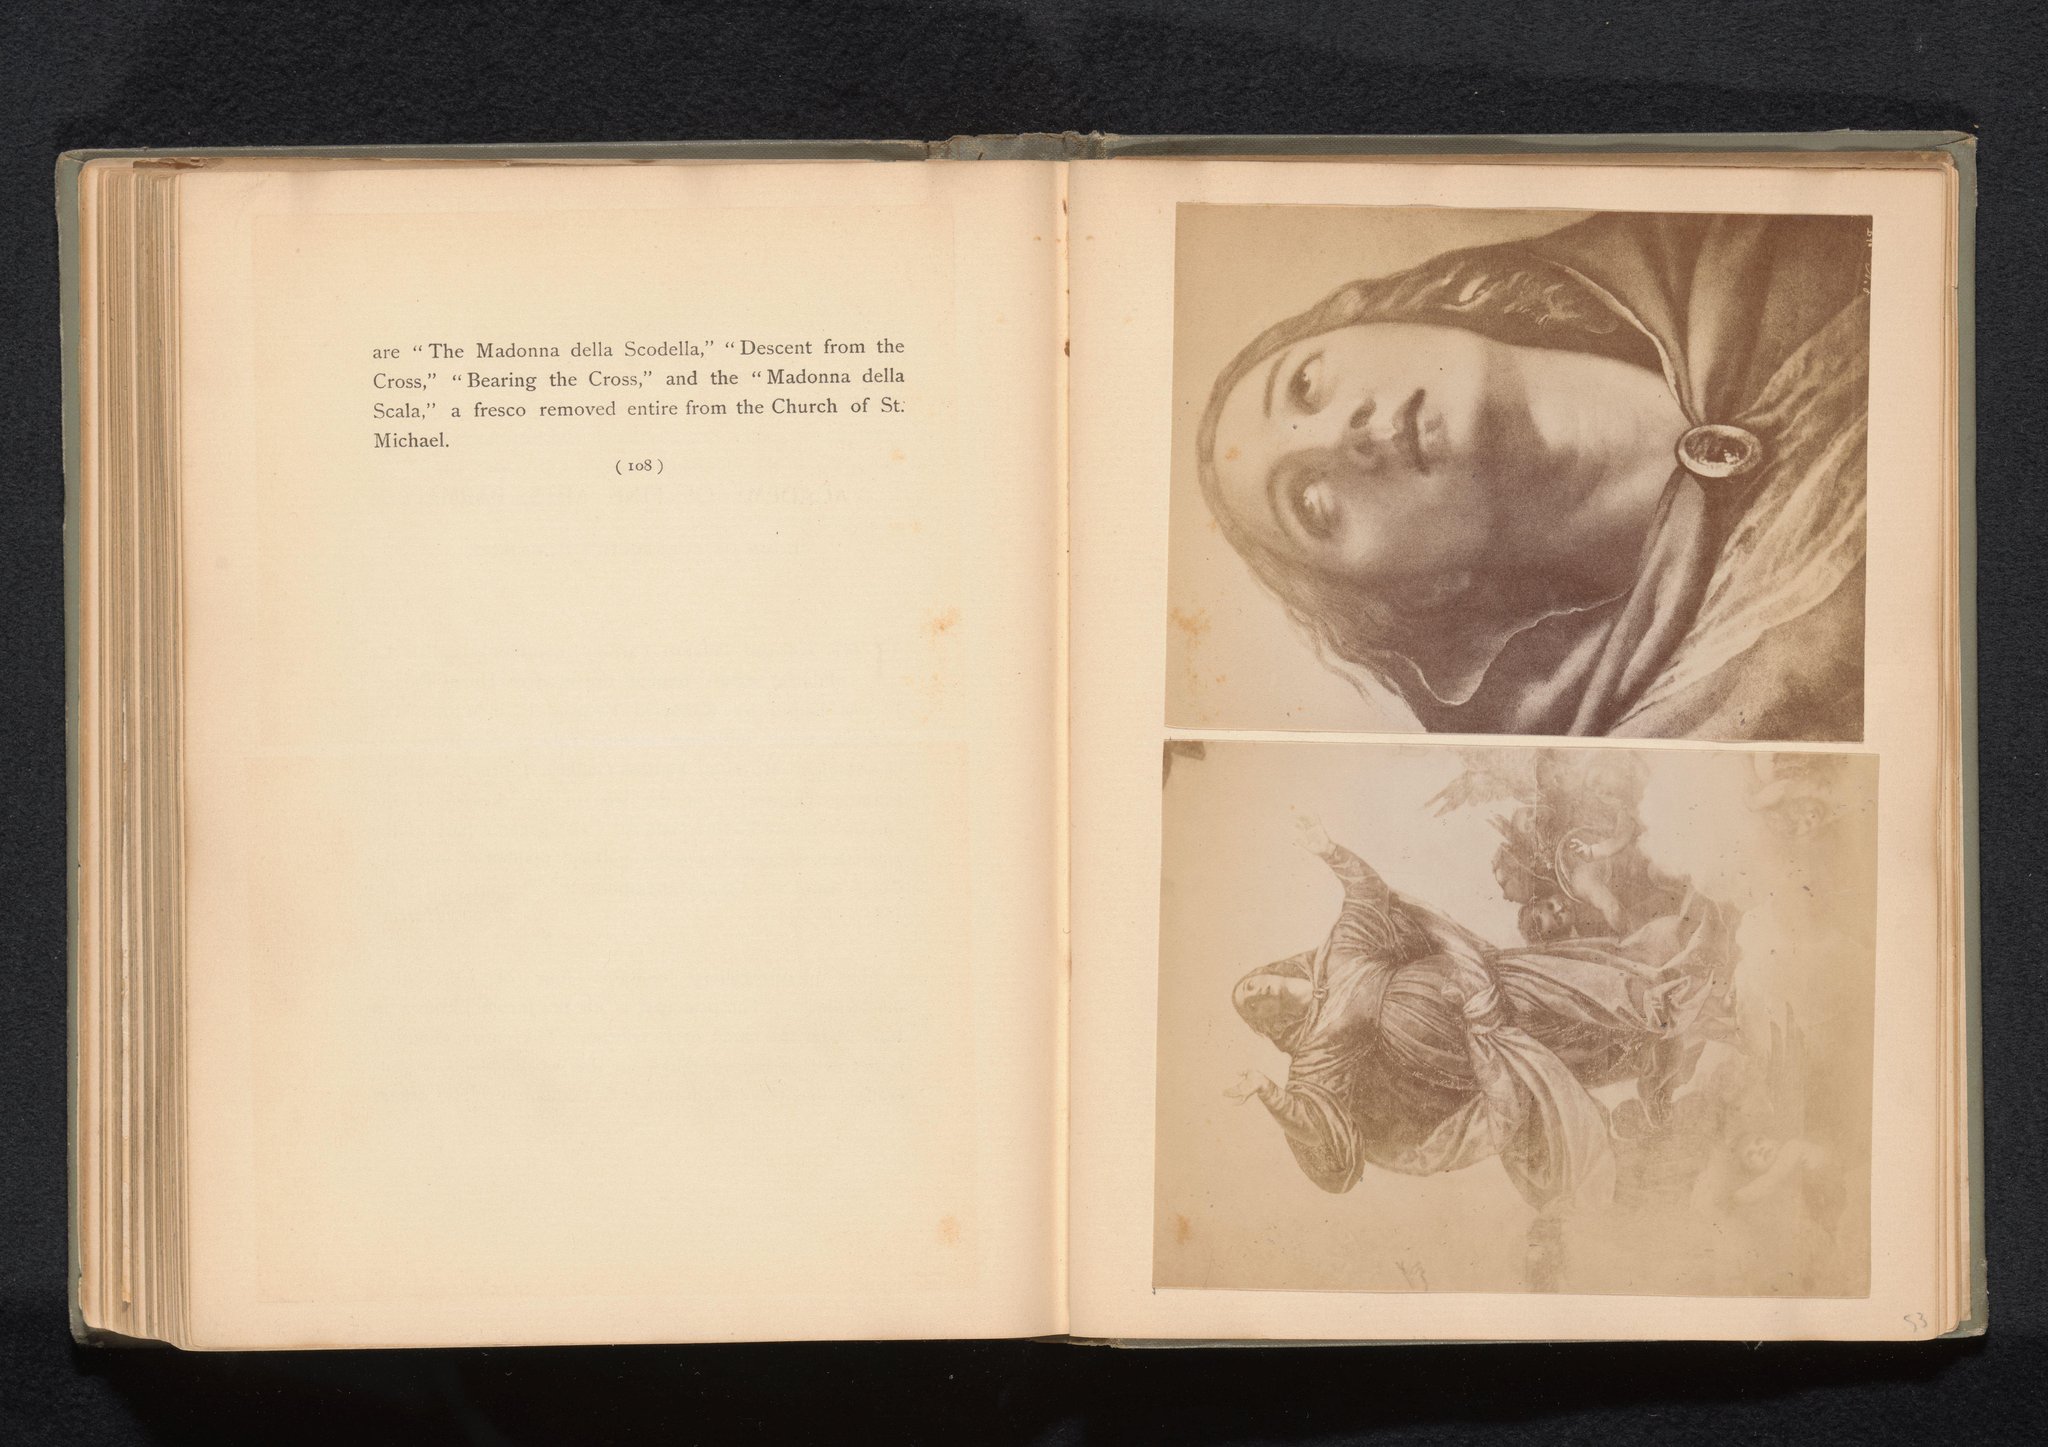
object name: reproduction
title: Fotoreproductie van een prent naar een schilderij, voorstellende de Madonna van de heilige Hiëronymus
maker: Anonymous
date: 1882-1887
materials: photographic support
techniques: albumen print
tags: madonna: i.e. mary with the christ-child